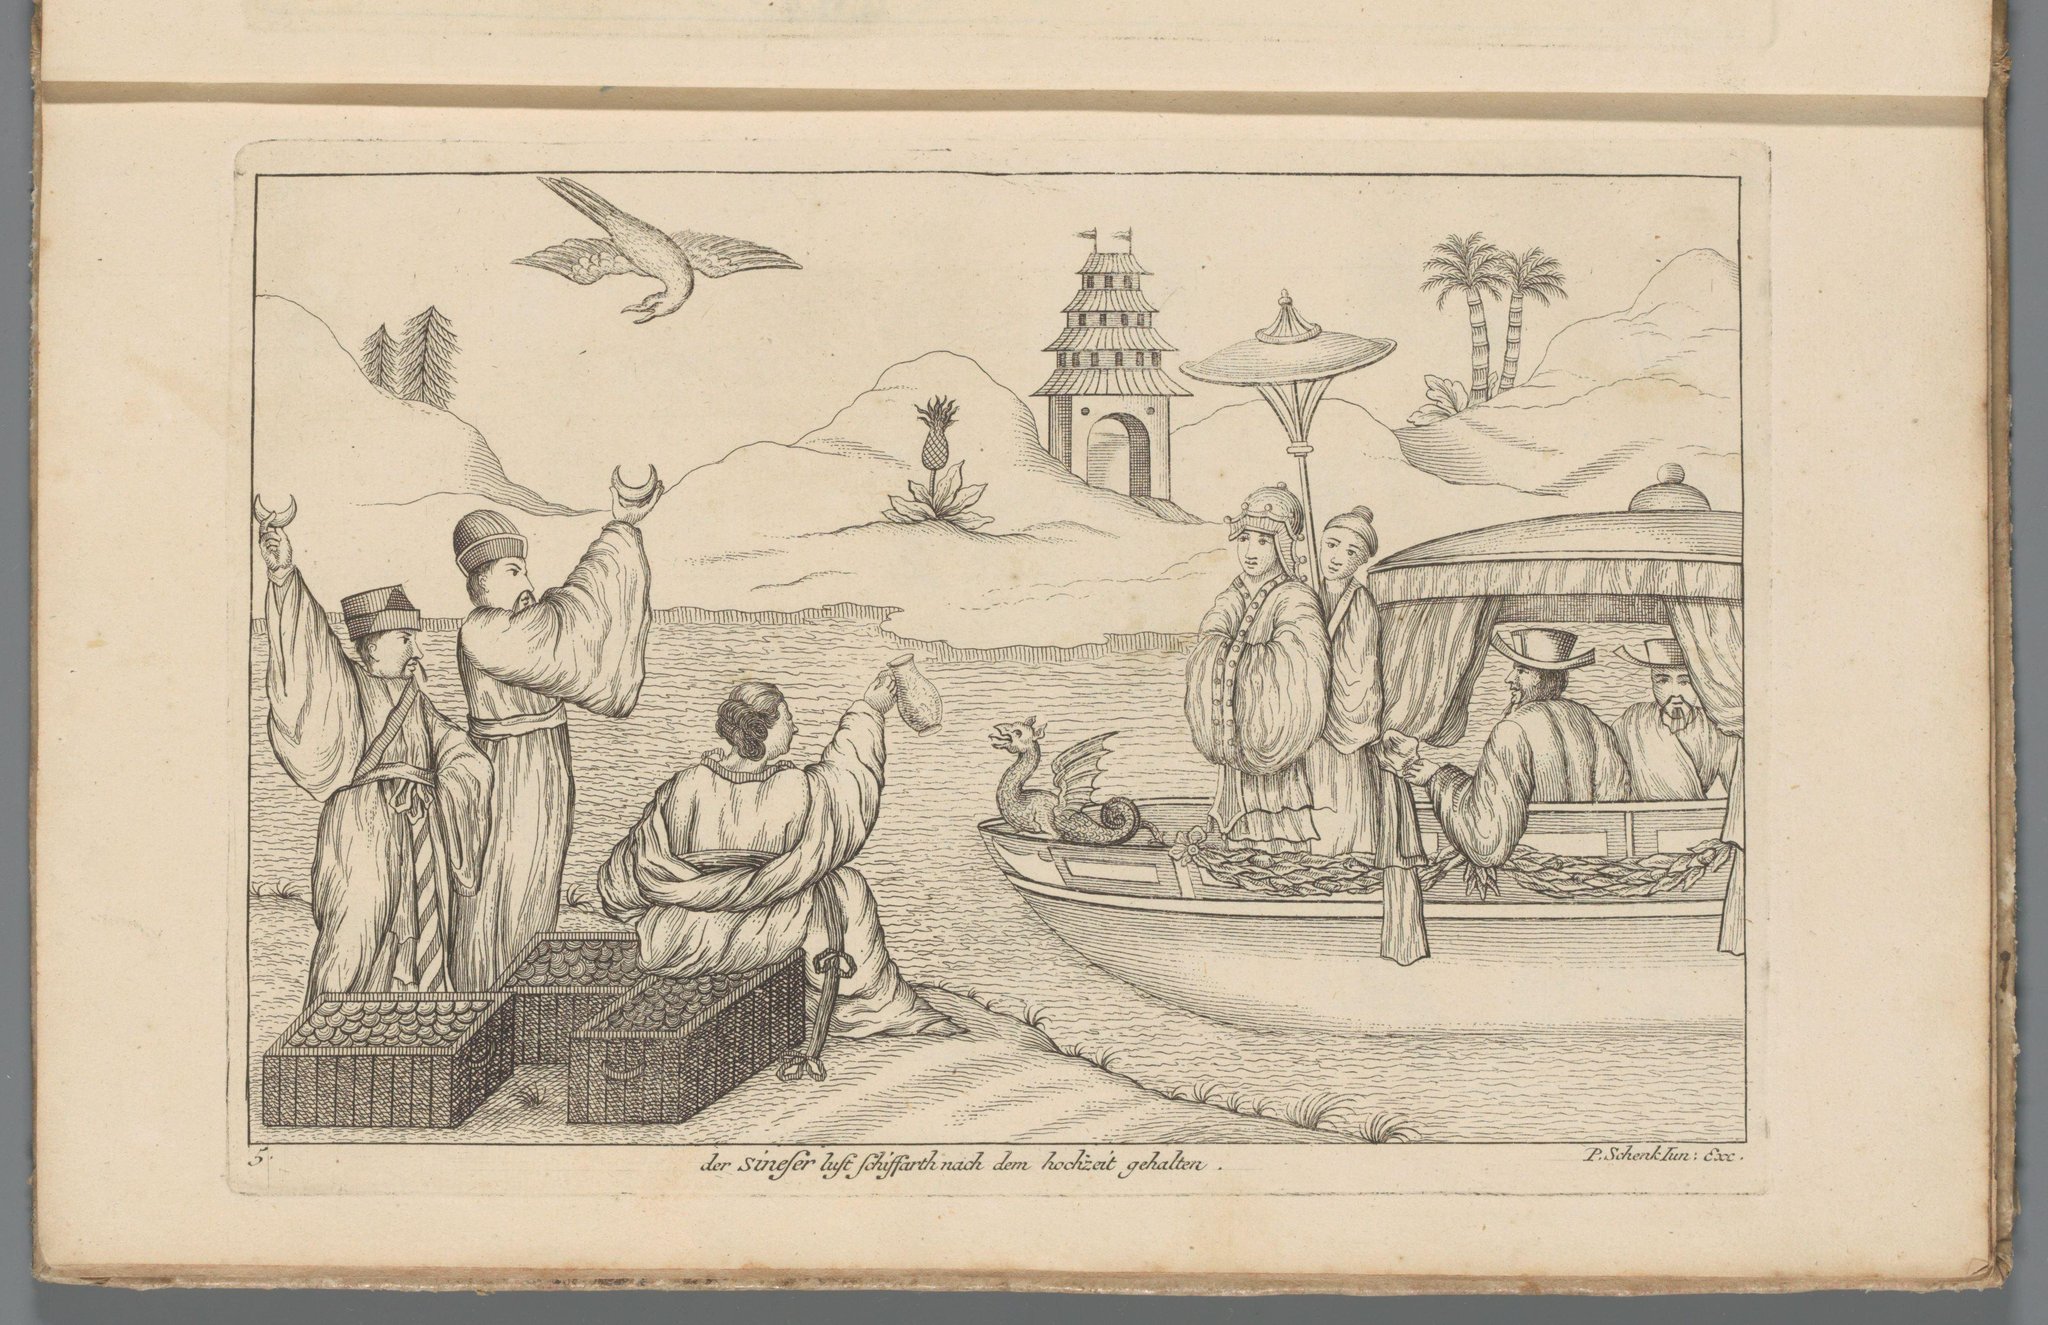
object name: ornament print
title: Chinese gebruiken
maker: pieter schenk (ii)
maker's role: draughtsman, print maker, publisher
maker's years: 1693-1775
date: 1727-1775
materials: paper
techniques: etching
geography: amsterdam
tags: chinese, ships (in general), (civil) marriage ceremonies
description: Nadat een huwelijk is gesloten, wordt een vaartocht op een schip gemaakt. De bruid staat op het schip onder een parasol. Op de oever drie figuren, waarvan twee met een halve maan in de hand. Prent maakt deel uit van een album.